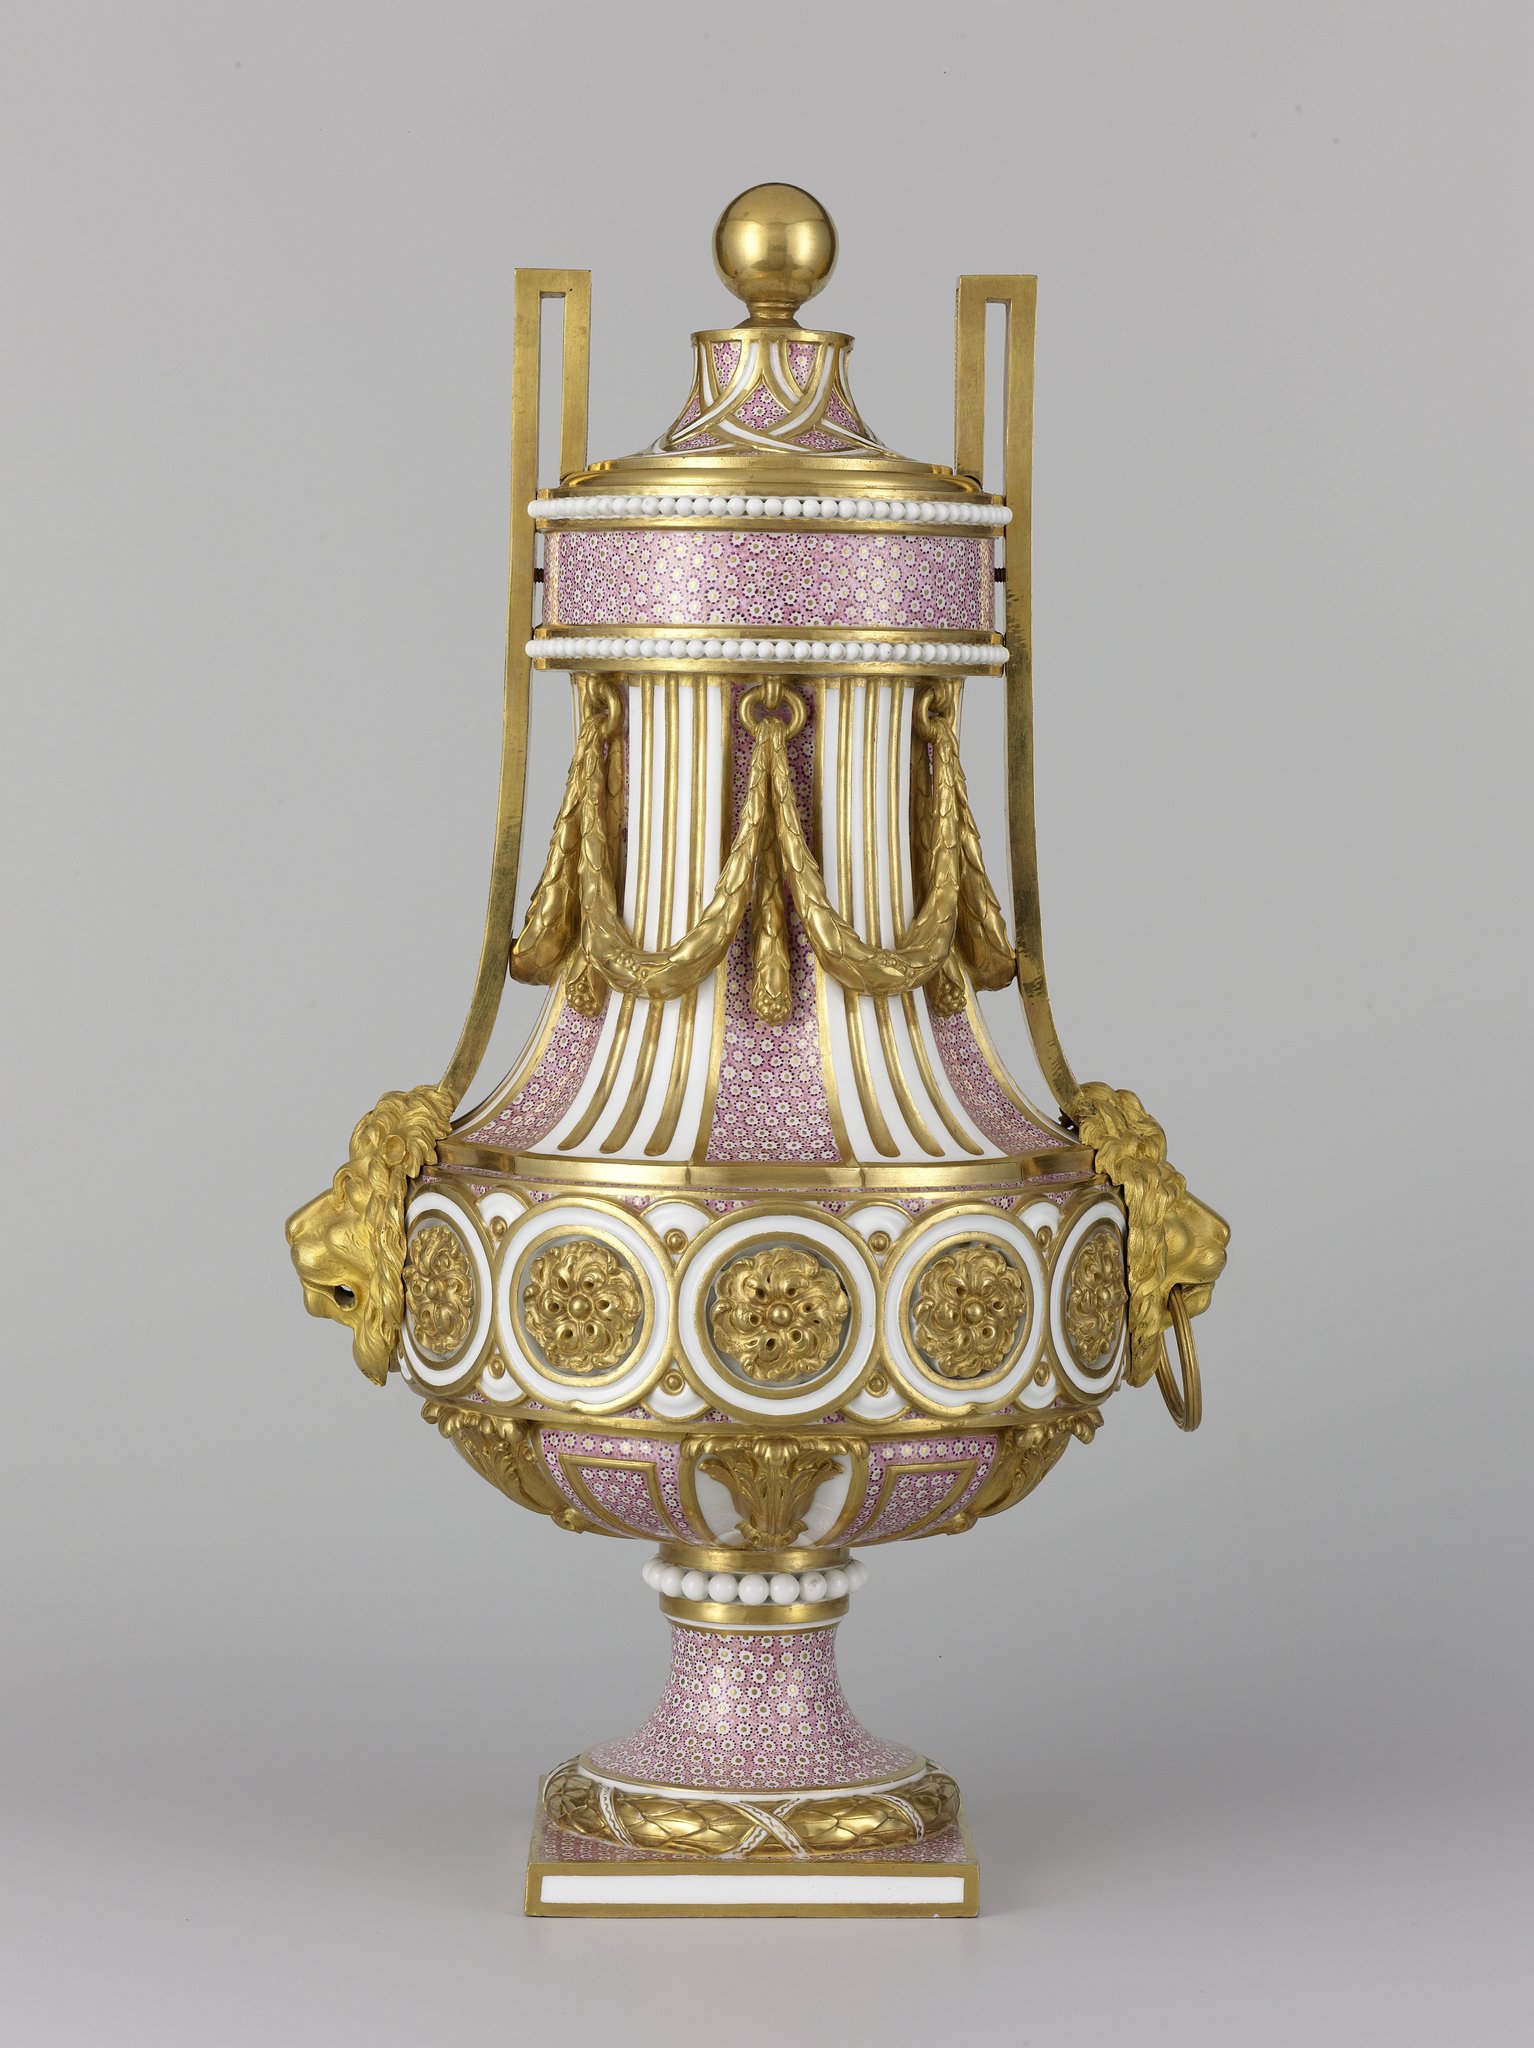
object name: vase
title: Pair of vases (vase grec Duplessis rectifié)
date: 1780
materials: bronze, porcelain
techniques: gilding, painted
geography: sèvres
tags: lion's head ~ ornament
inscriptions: number: ‘859.’, factory mark, inscription, mark: ‘gn Duplessi/ vase Grec rectifie 2 (of rectifier)’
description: In 1782 the Russian crown prince –later Tsar Paul I –and his consort sojourned in Paris. They visited the porcelain factory in Sèvres, where King Louis XVI made them a generous gift of numerous pieces of porcelain. They themselves bough many items, including these two vases. The couple displayed them in their palace in Pavlovsk.